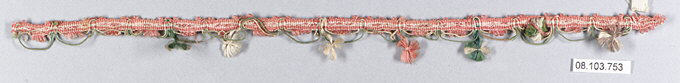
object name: gimp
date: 1734-1766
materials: silk